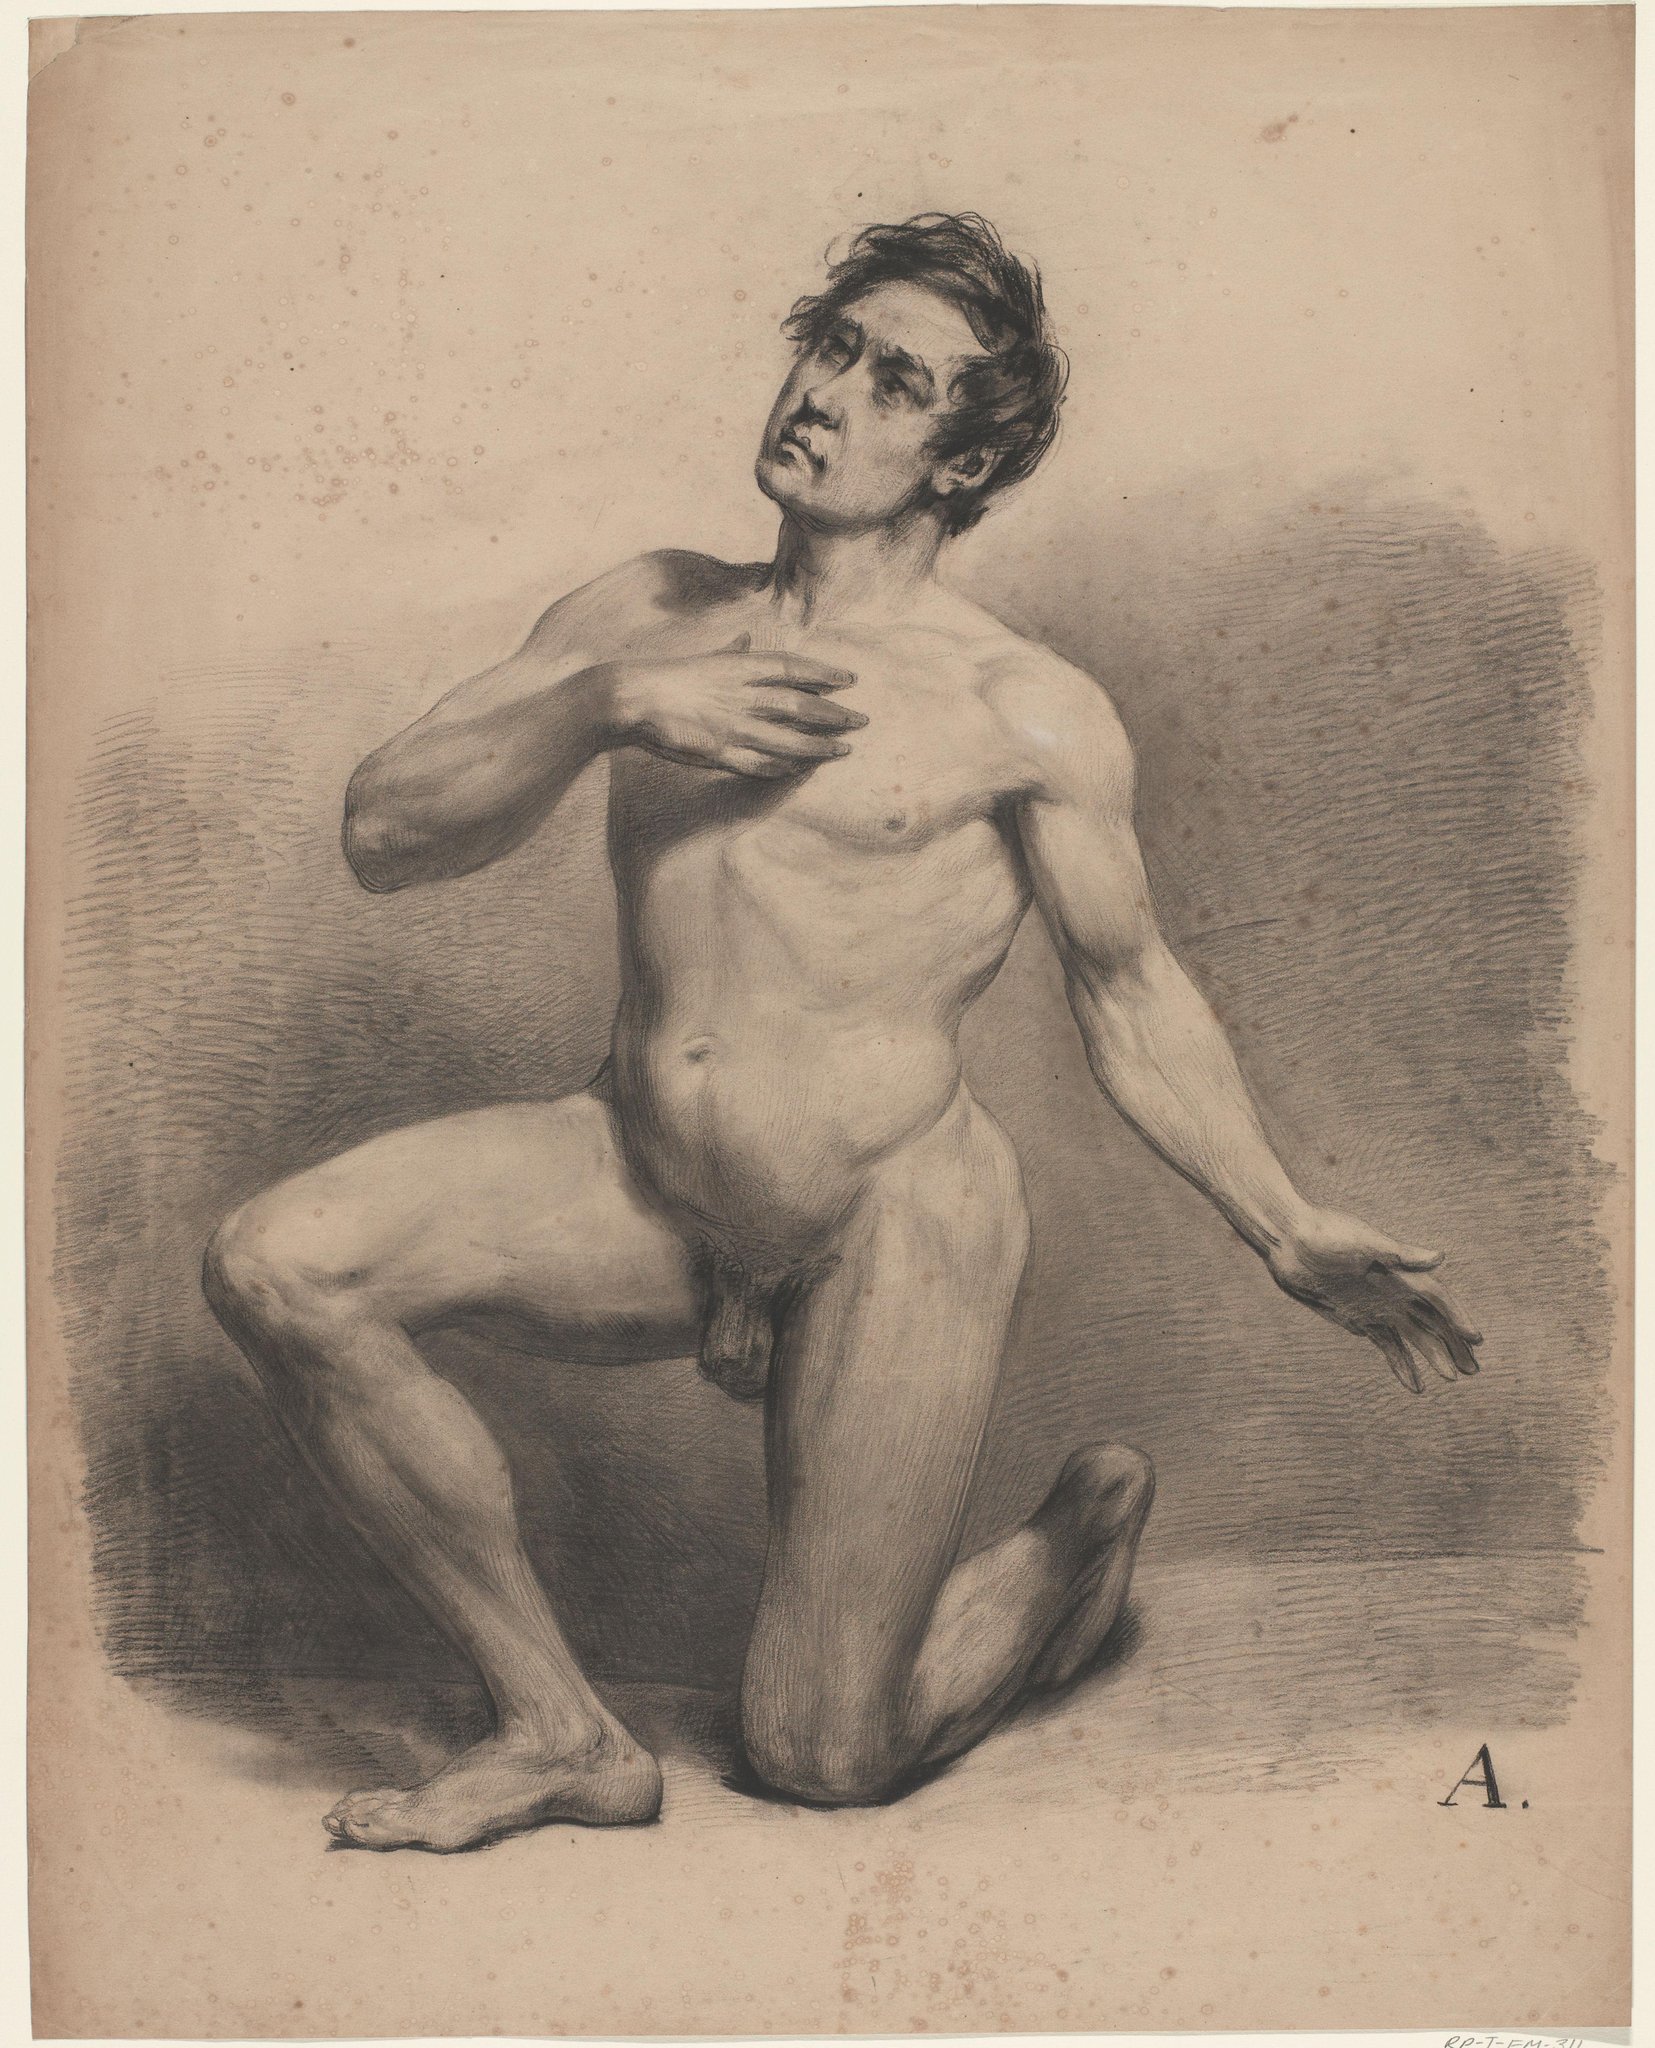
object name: drawing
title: Knielend mannelijk naakt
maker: Anonymous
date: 1800-1900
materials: chalk, paper